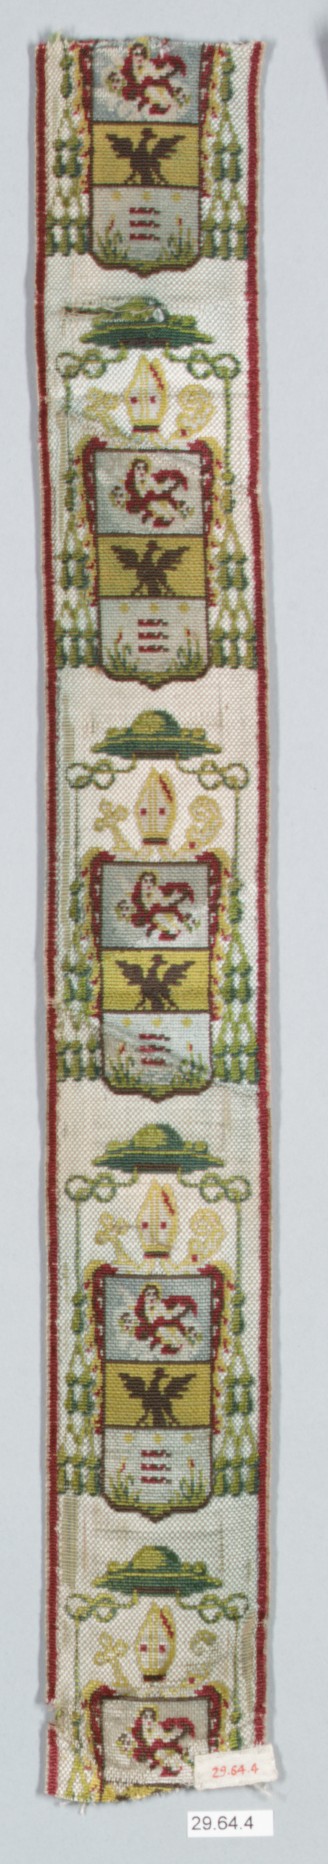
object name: galloon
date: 1701-1900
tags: coat of arms